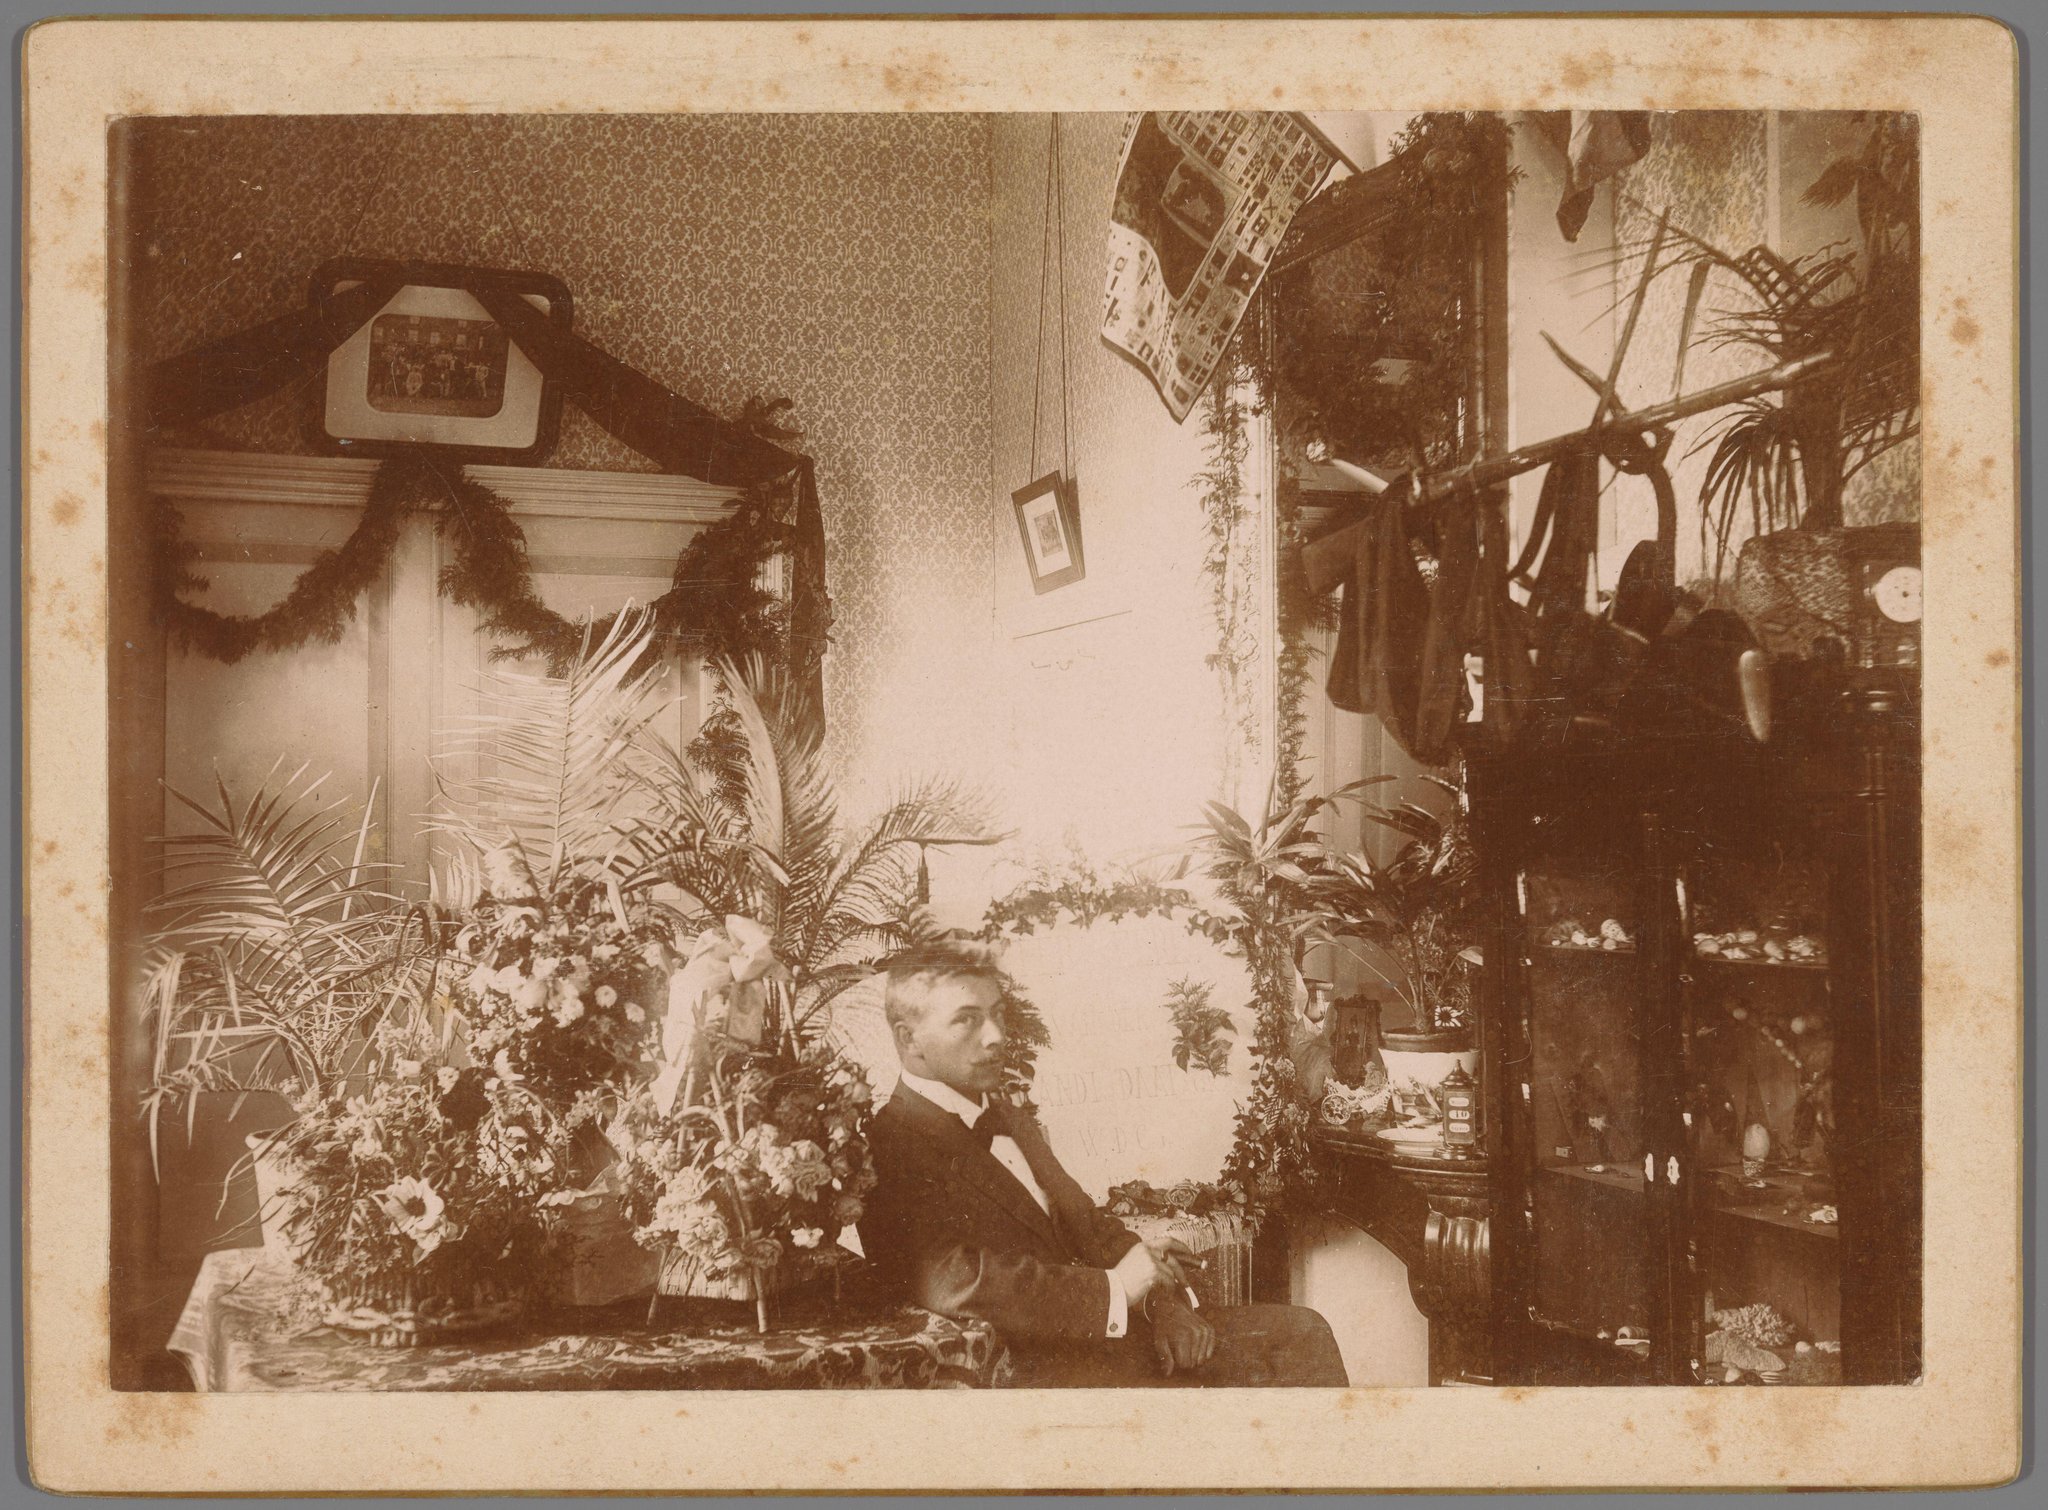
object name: photograph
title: Portret van een onbekende student bij het behalen van zijn kandidaatsexamen, Wageningen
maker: Anonymous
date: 1892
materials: paper, cardboard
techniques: collodion silver print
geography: wageningen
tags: student life, historical persons not known by name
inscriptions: inscription: ‘Wageningen 1892/ viering candidaatsexamen’